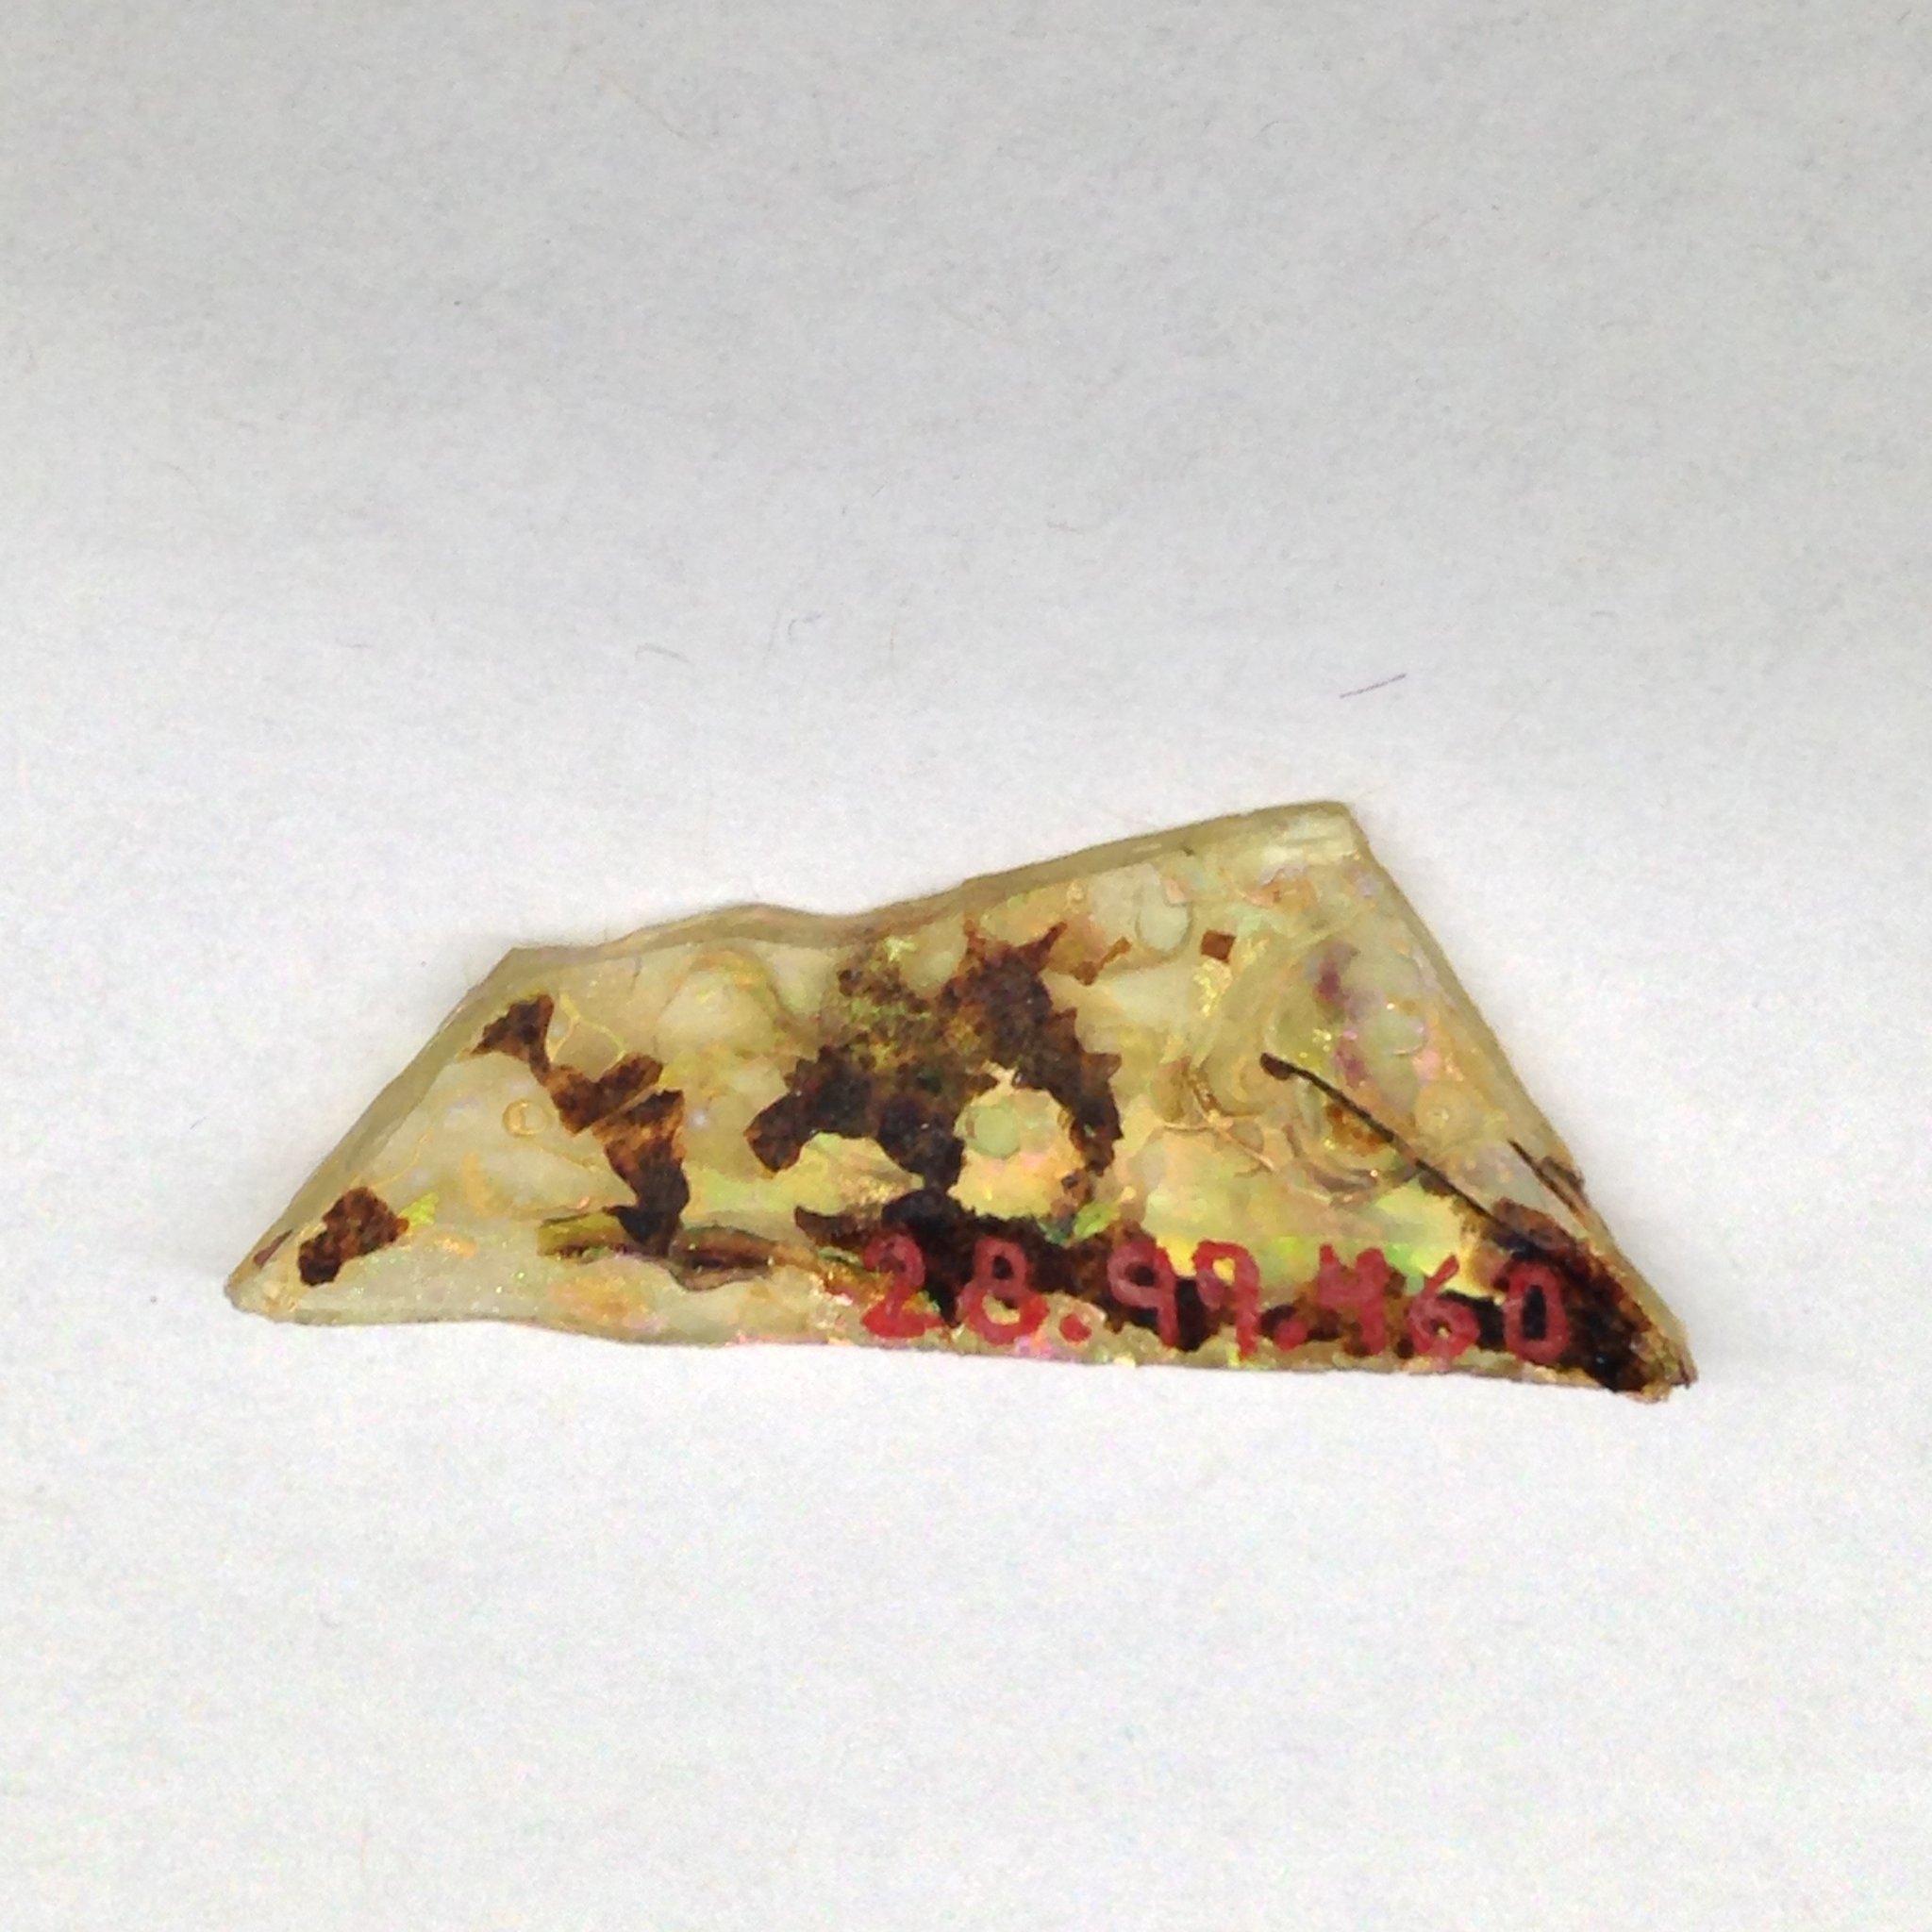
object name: fragment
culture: european or middle eastern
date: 1150-1250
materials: ceramic, glass